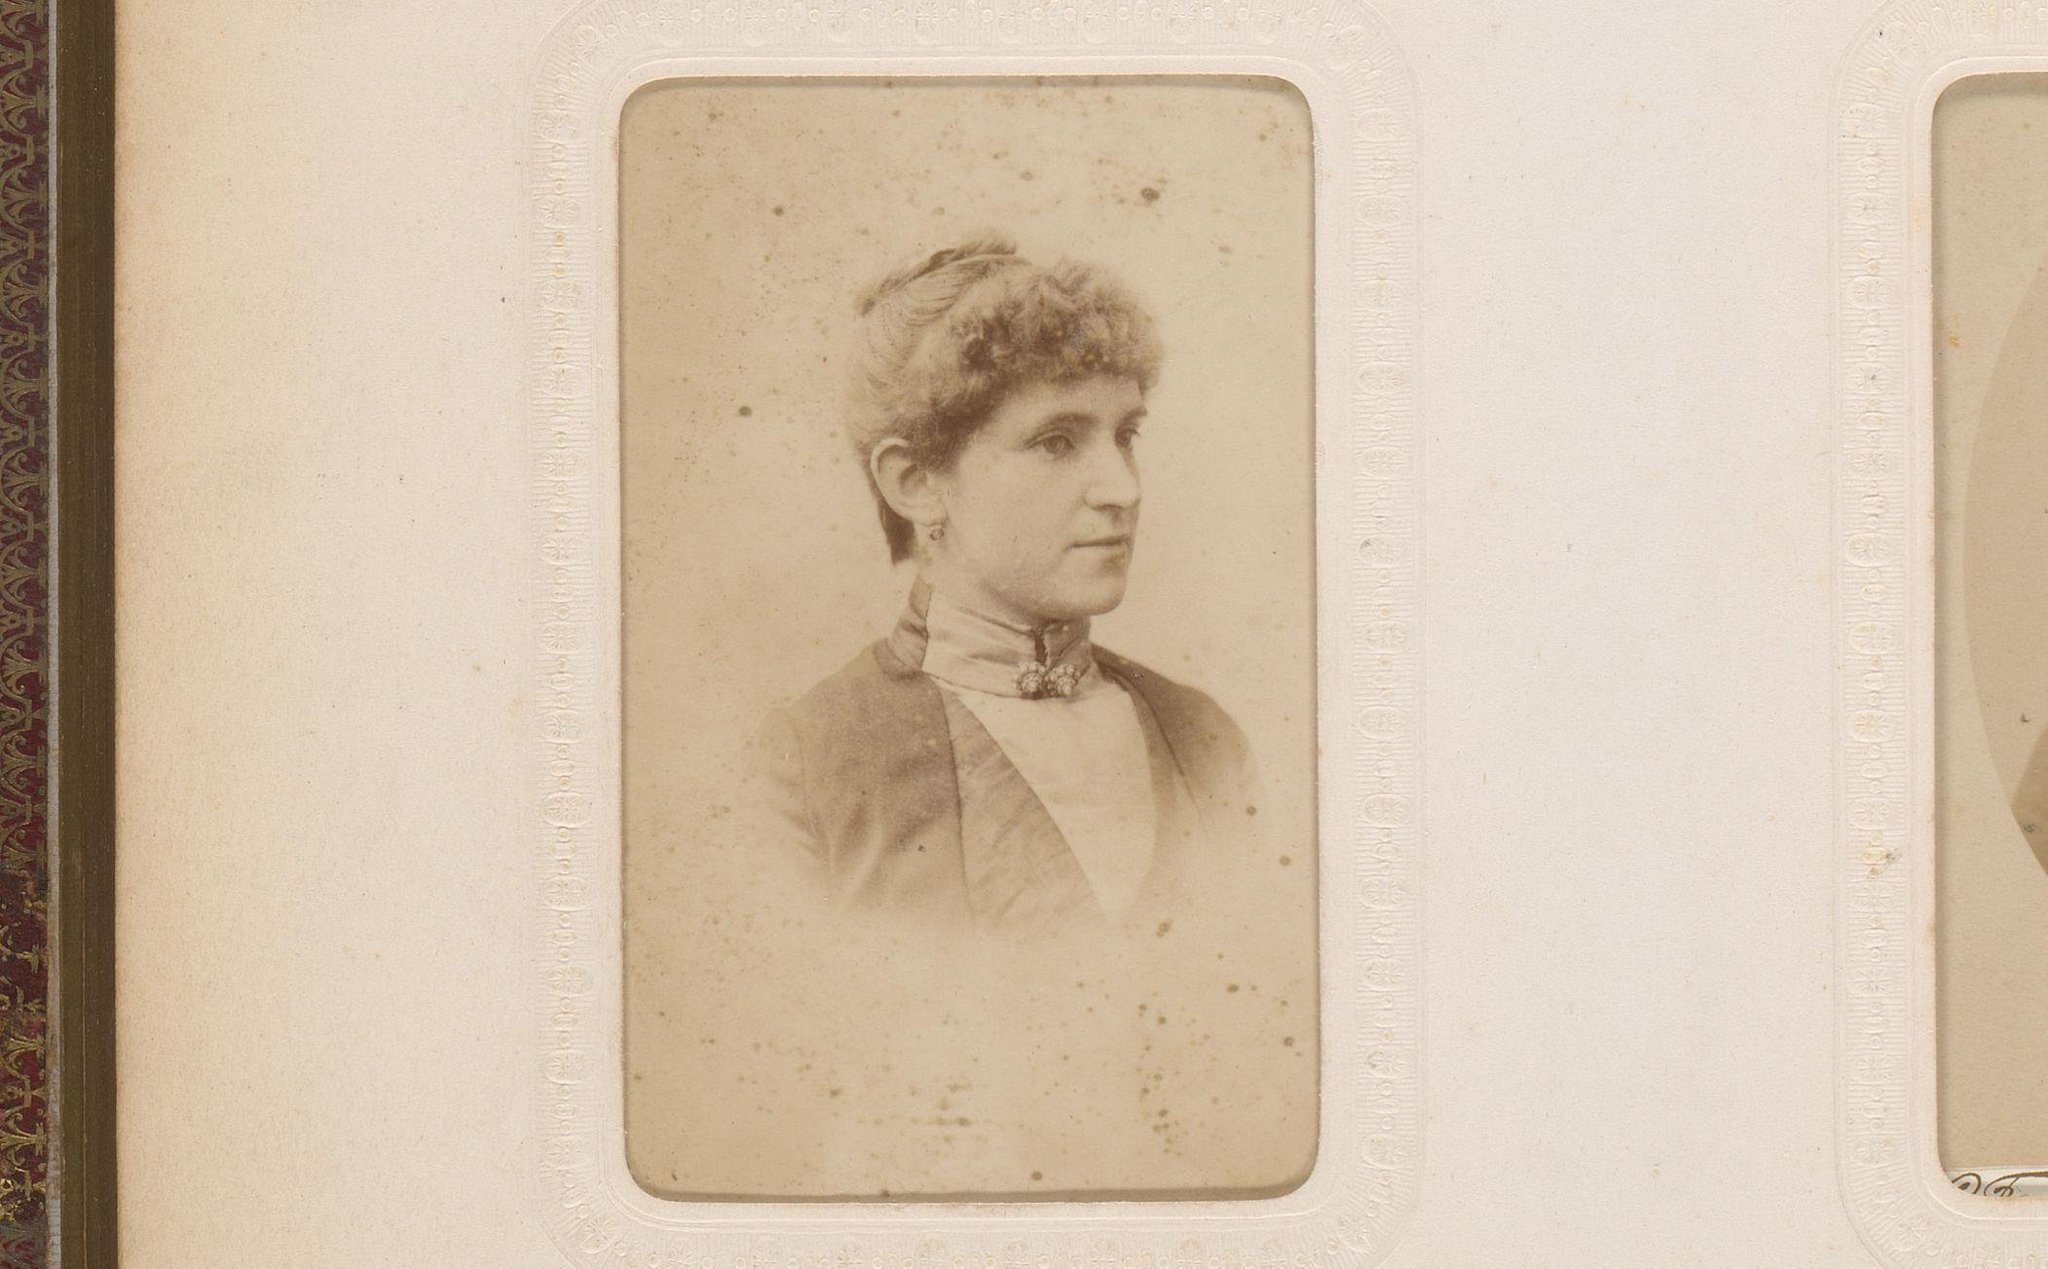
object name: carte de visite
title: Portret van een vrouw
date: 1860-1900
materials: cardboard, photographic support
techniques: albumen print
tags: historical persons - bb - woman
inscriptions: inscription: ‘C.F. & L.J. Cordes/ 's Bosch Haarlem’